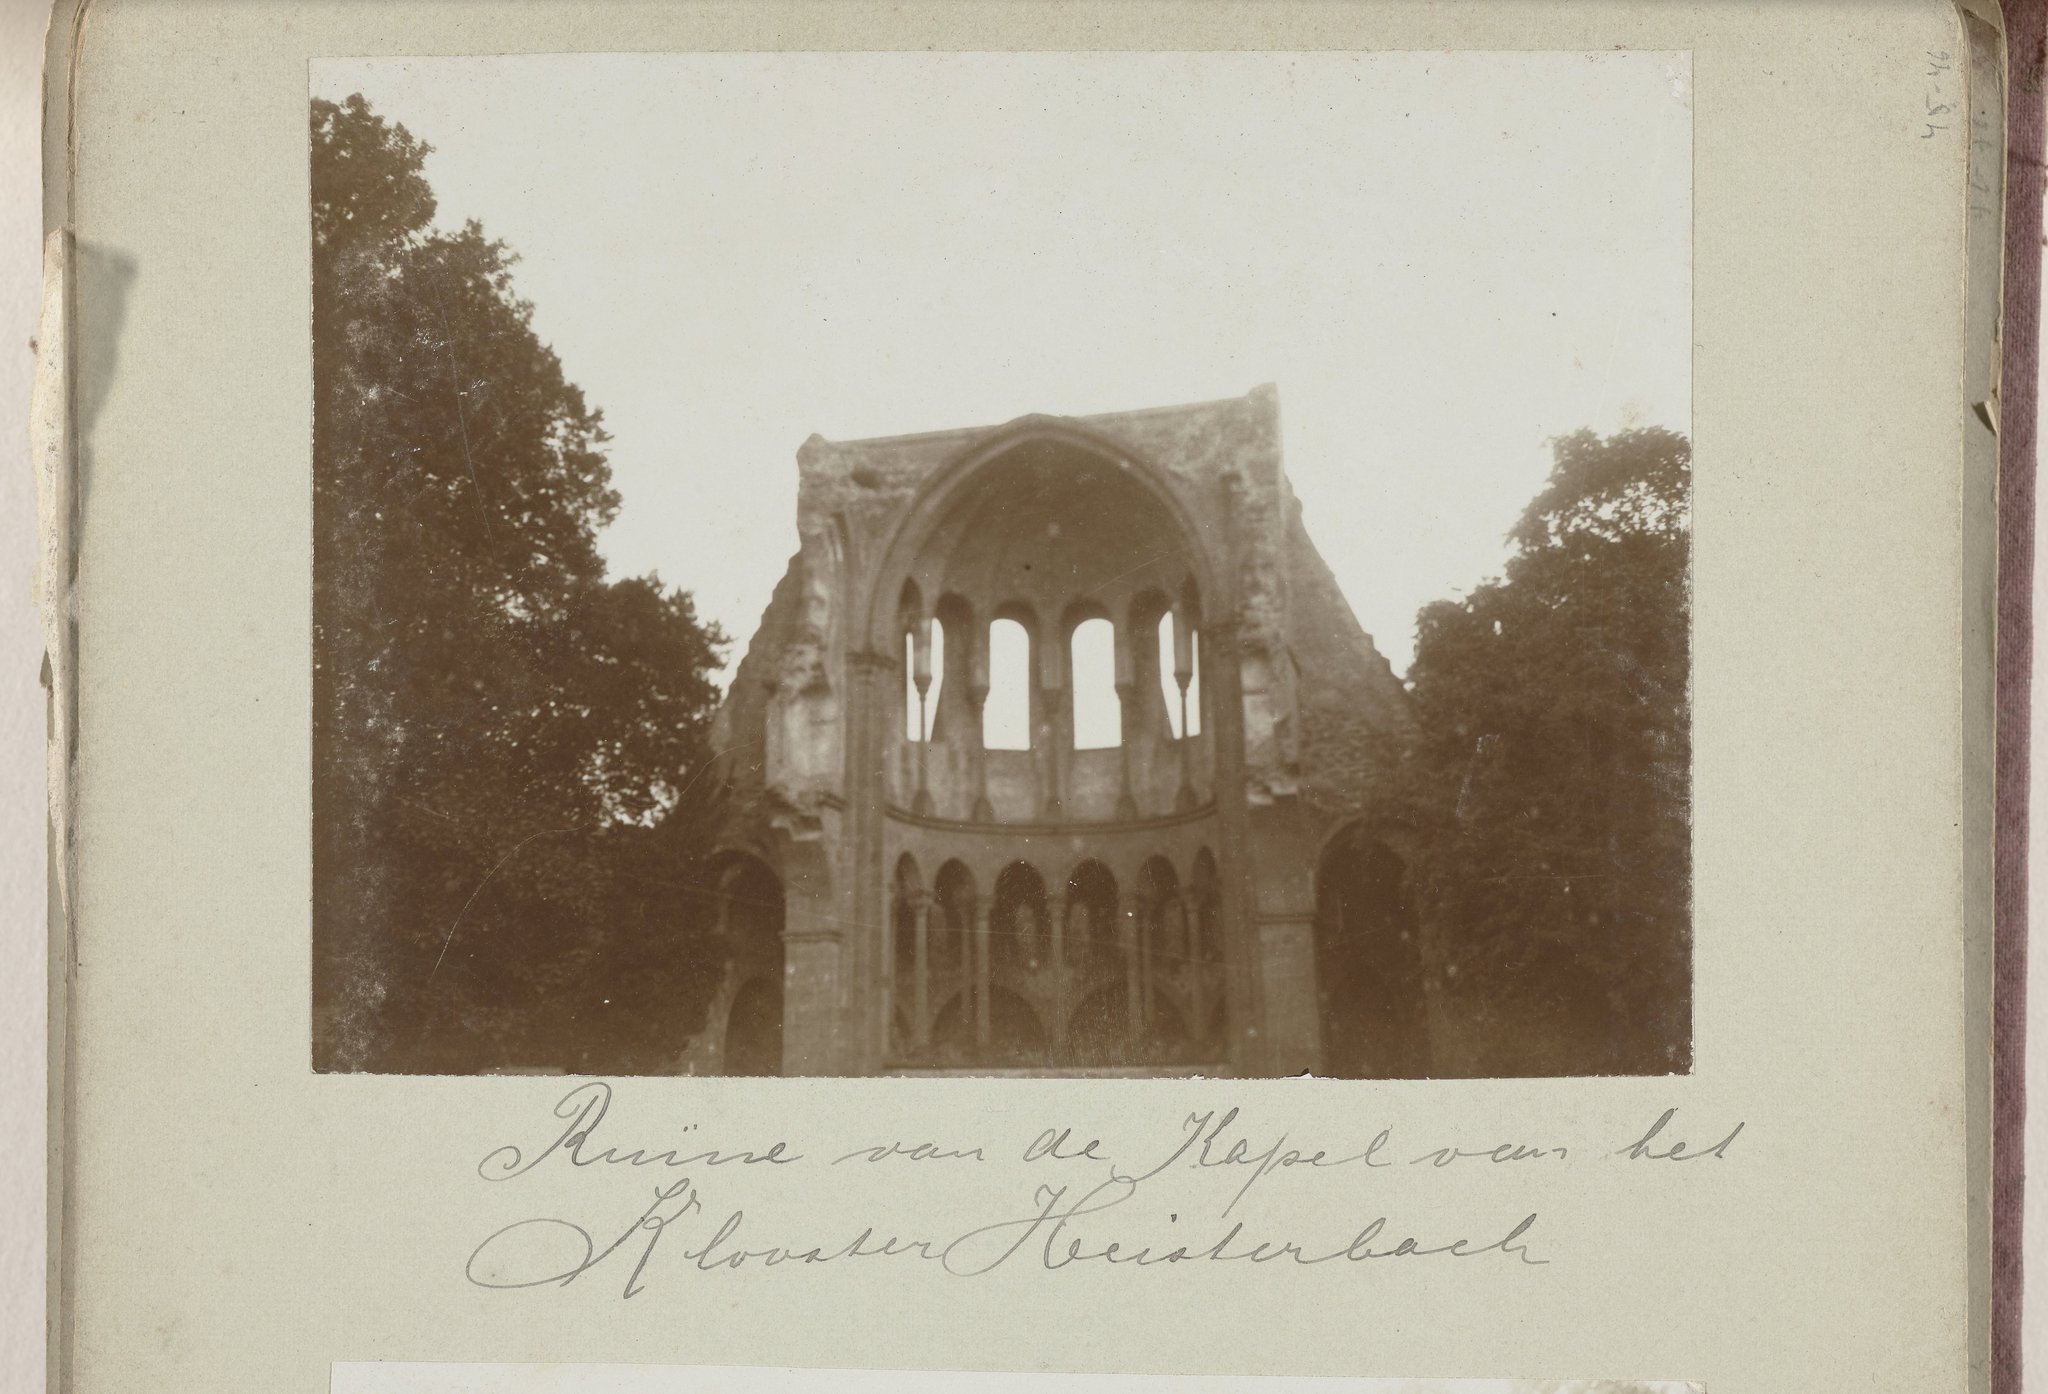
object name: photograph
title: Ruïne van de Kapel van het Klooster Heisterbach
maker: david vermeulen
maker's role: fotograaf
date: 1895-1905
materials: paper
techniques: collodion silver print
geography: heisterbach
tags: ruin of church, monastery, etc.